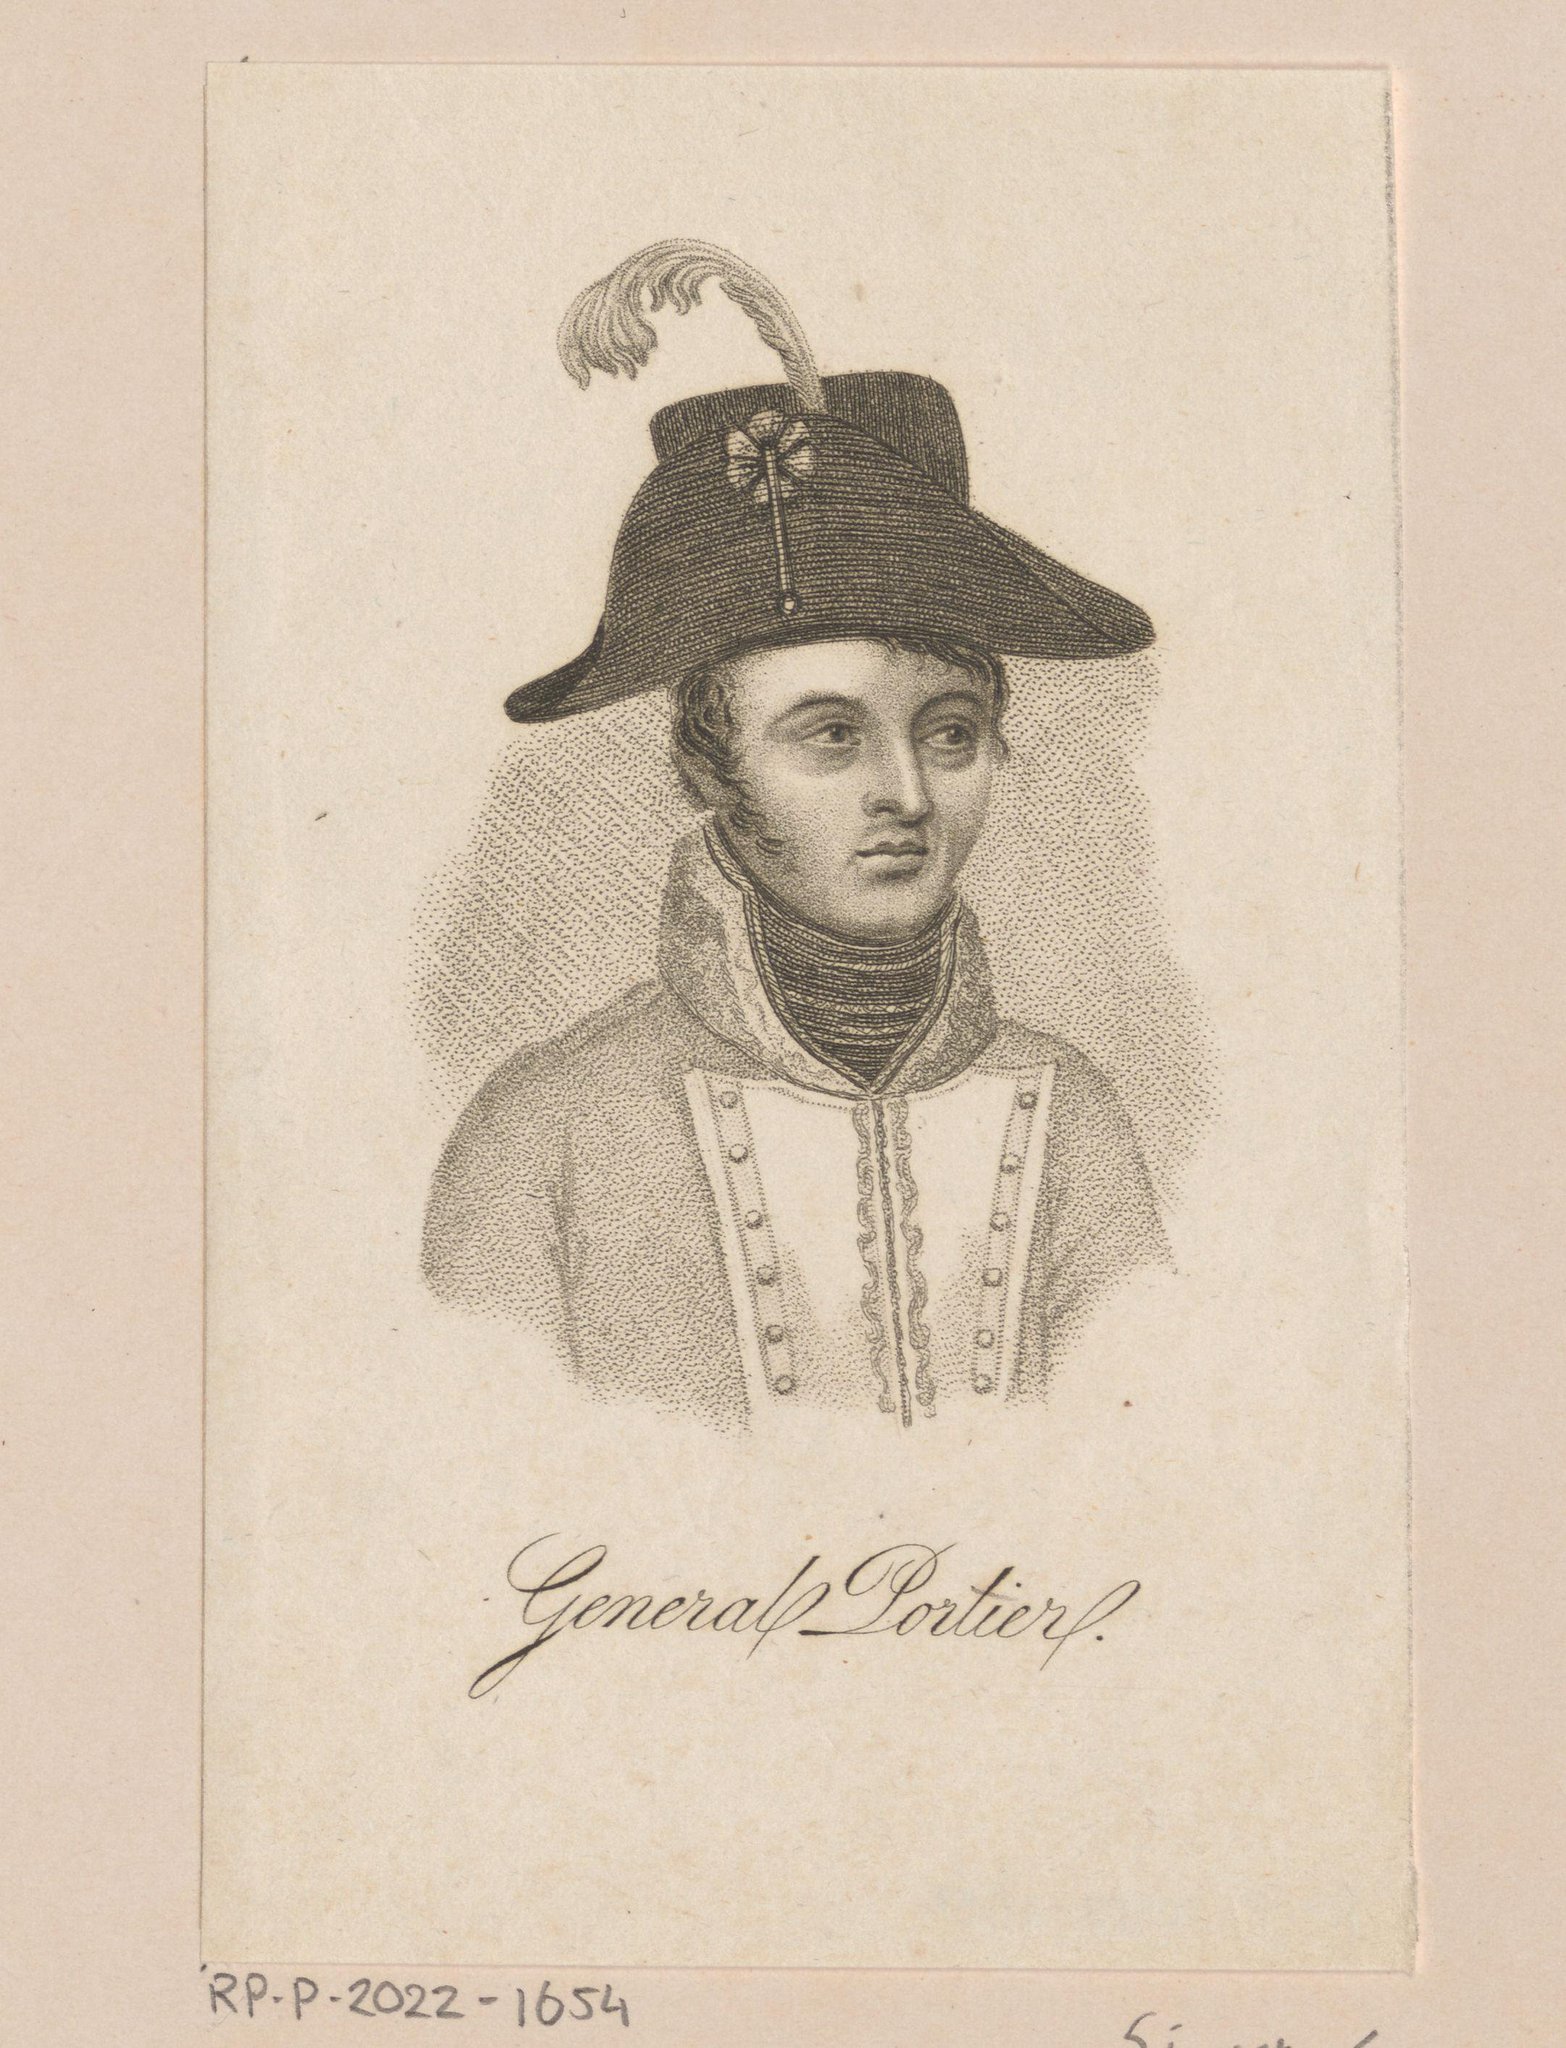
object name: print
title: General Portier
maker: Anonymous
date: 1750-1899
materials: paper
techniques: etching, roulette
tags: commander-in-chief, general, marshal, historical persons not known by name